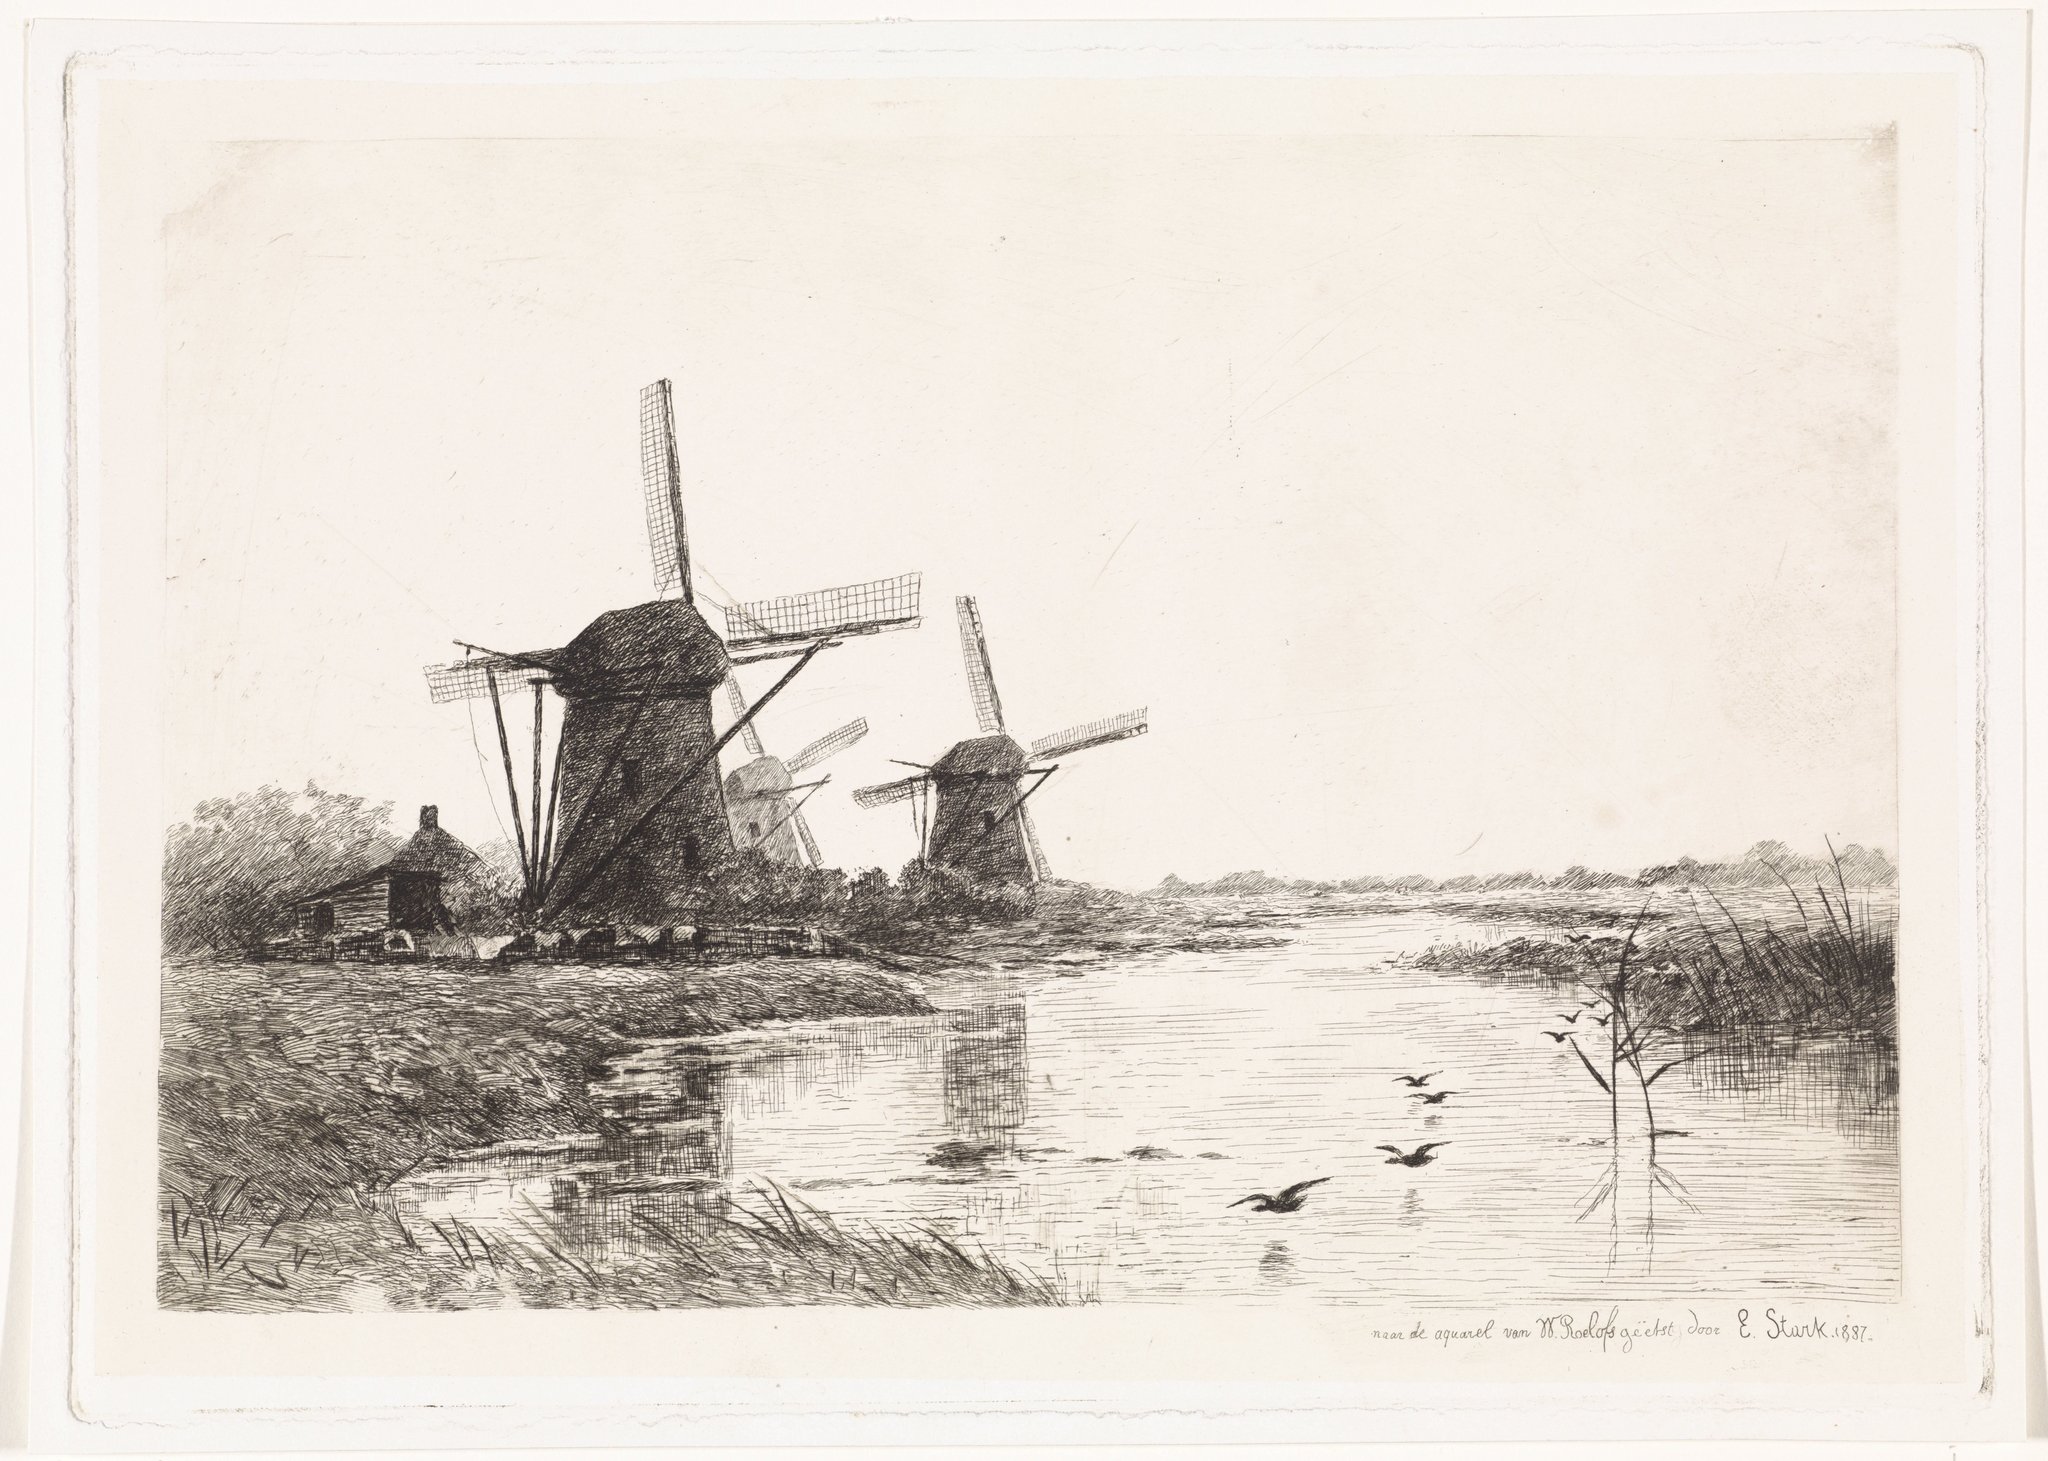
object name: print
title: Landschap met drie molens langs een vaart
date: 1887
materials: paper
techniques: etching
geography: nieuwer-amstel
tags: canal, windmill in landscape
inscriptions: collector's mark: Lugt 2228